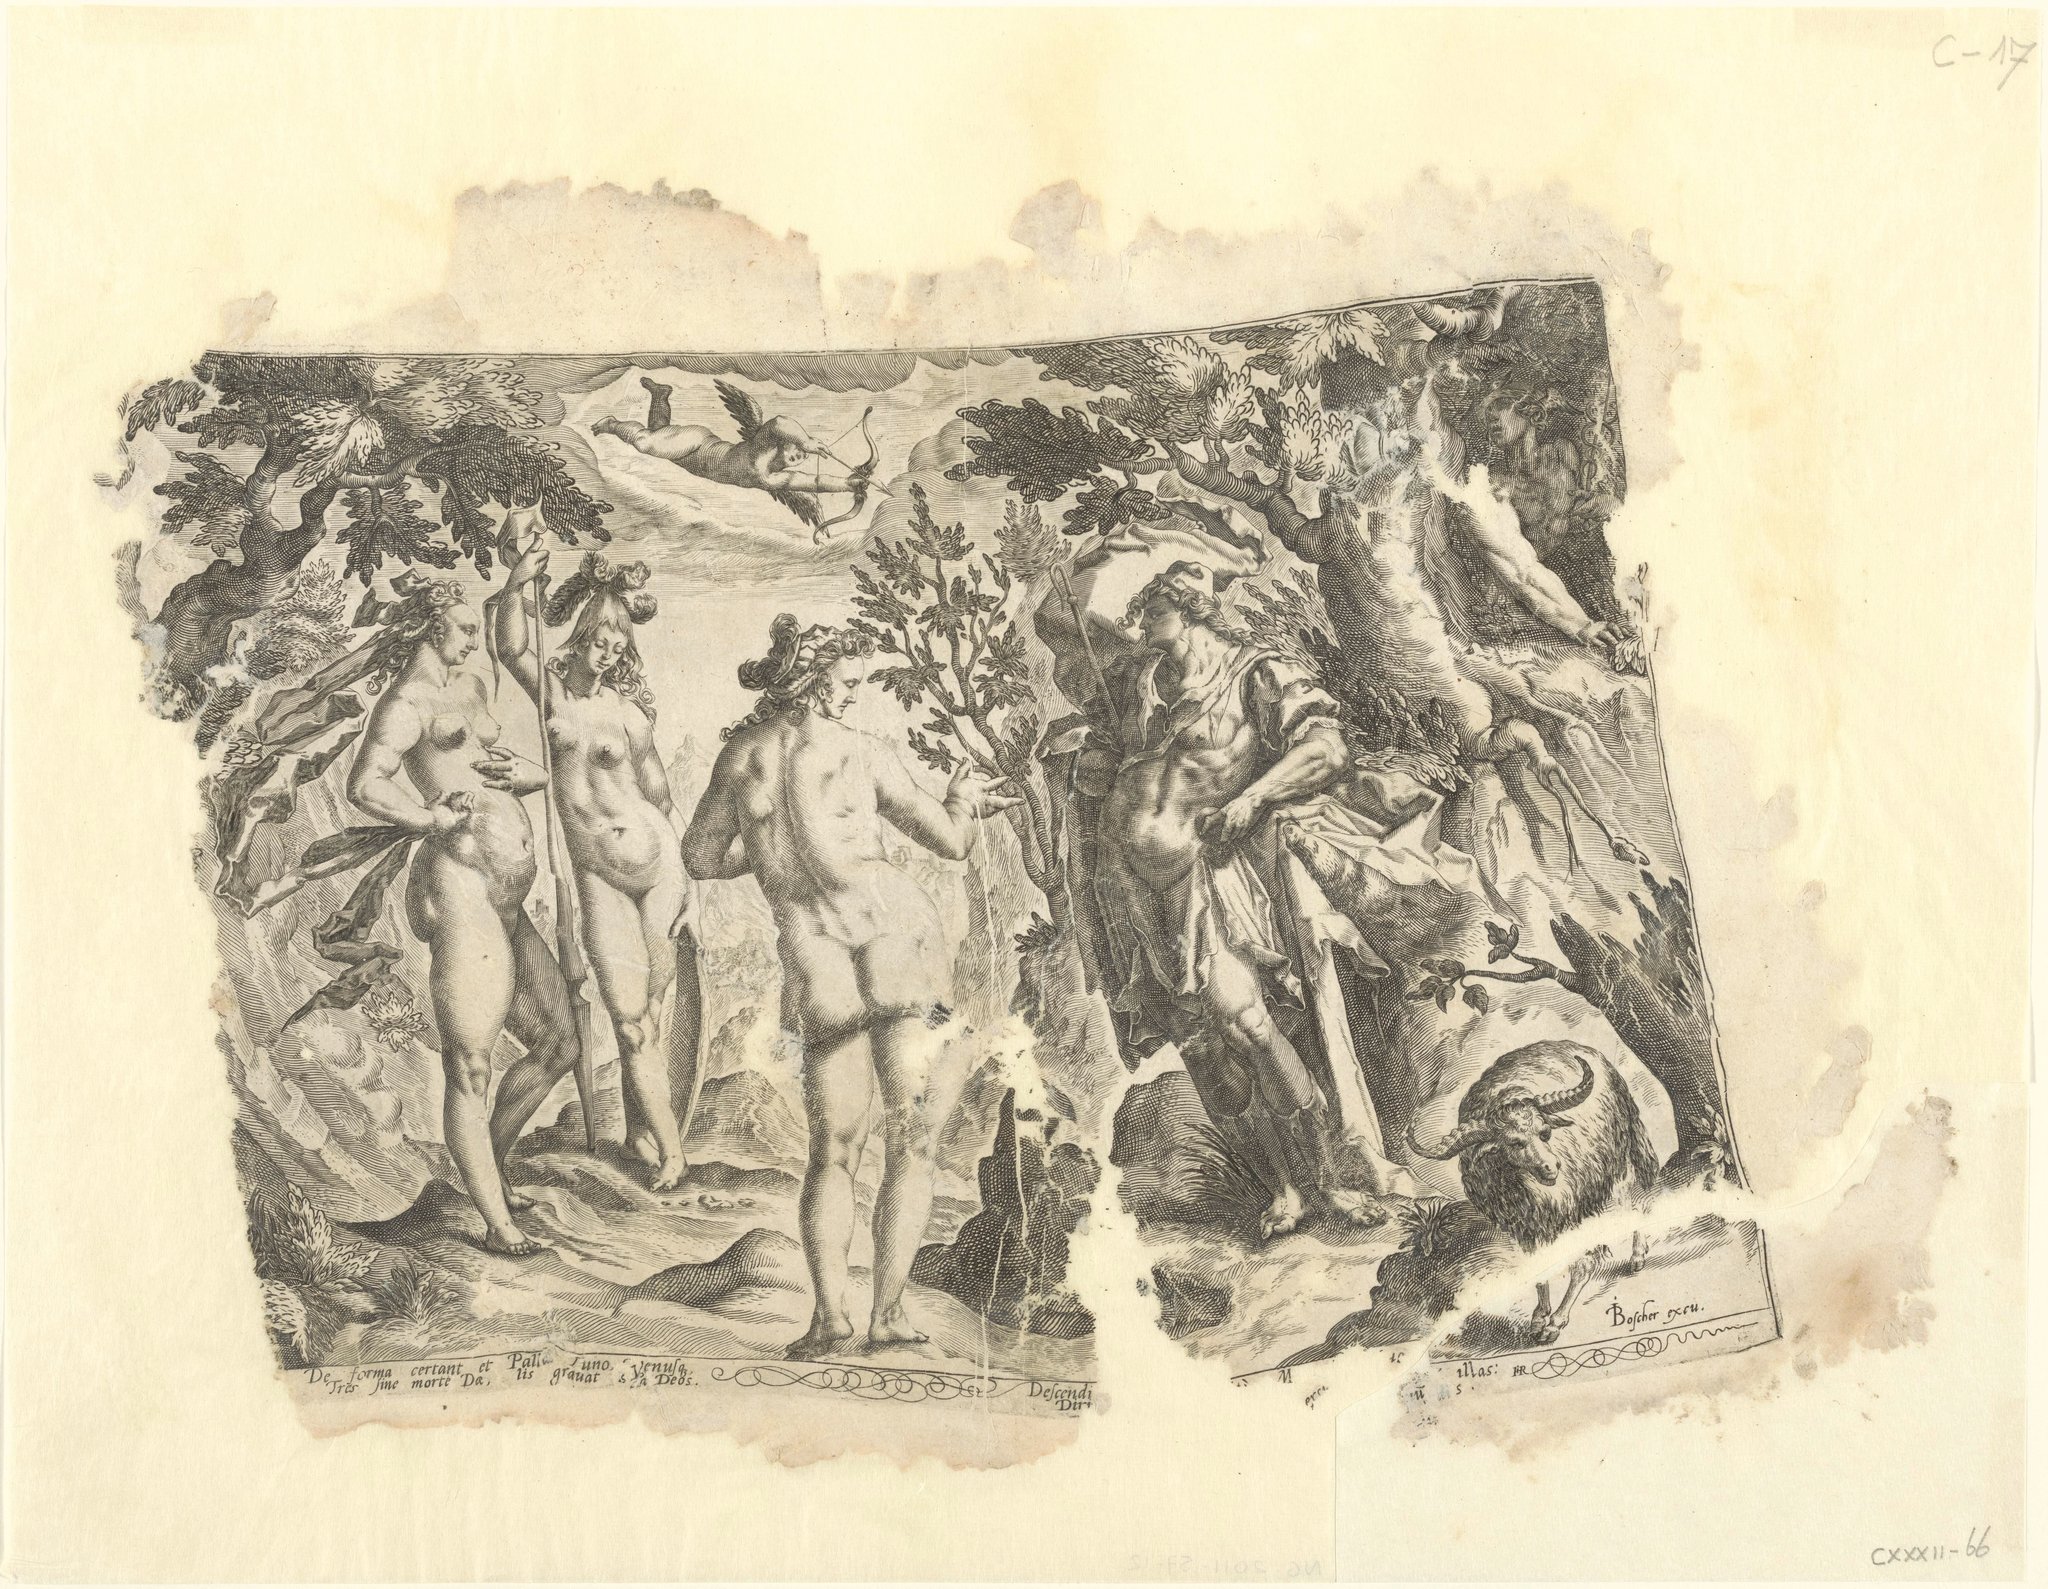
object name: print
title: Oordeel van Paris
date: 1580-1596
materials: paper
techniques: engraving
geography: amsterdam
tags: the judgement of paris (mercury present)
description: De prenten in de Nova Zembla collectie zijn tijdens een expeditie van Willem Barendsz en Jacob van Heemskerk in 1596-1597 noodgedwongen in het winterkamp, het ‘Behouden Huis’, op het eiland achtergelaten. De prenten waren in één of meerdere stapels als handelswaar meegenomen vanuit Amsterdam. Bijna drie eeuwen later, in 1871, keerde de Noor Elling Carlsen terug naar Nova Zembla en vond daar de restanten van het ‘Behouden Huis, inclusief een groot deel van de inventaris. Een deel van de prenten, in de vorm van aaneengekoekte kluiten, werd toen ook teruggevonden. De papierkluiten waren soms op meerdere plekken gebroken. Tussen 1975-1979 zijn de prenten van elkaar gescheiden. Dit leverde in totaal ca. 1000 fragmenten van ca. 400 afdrukken van ca. 150 verschillende prenten op. Voor zover mogelijk zijn de fragmenten samengevoegd en zijn de prenten gereconstrueerd.